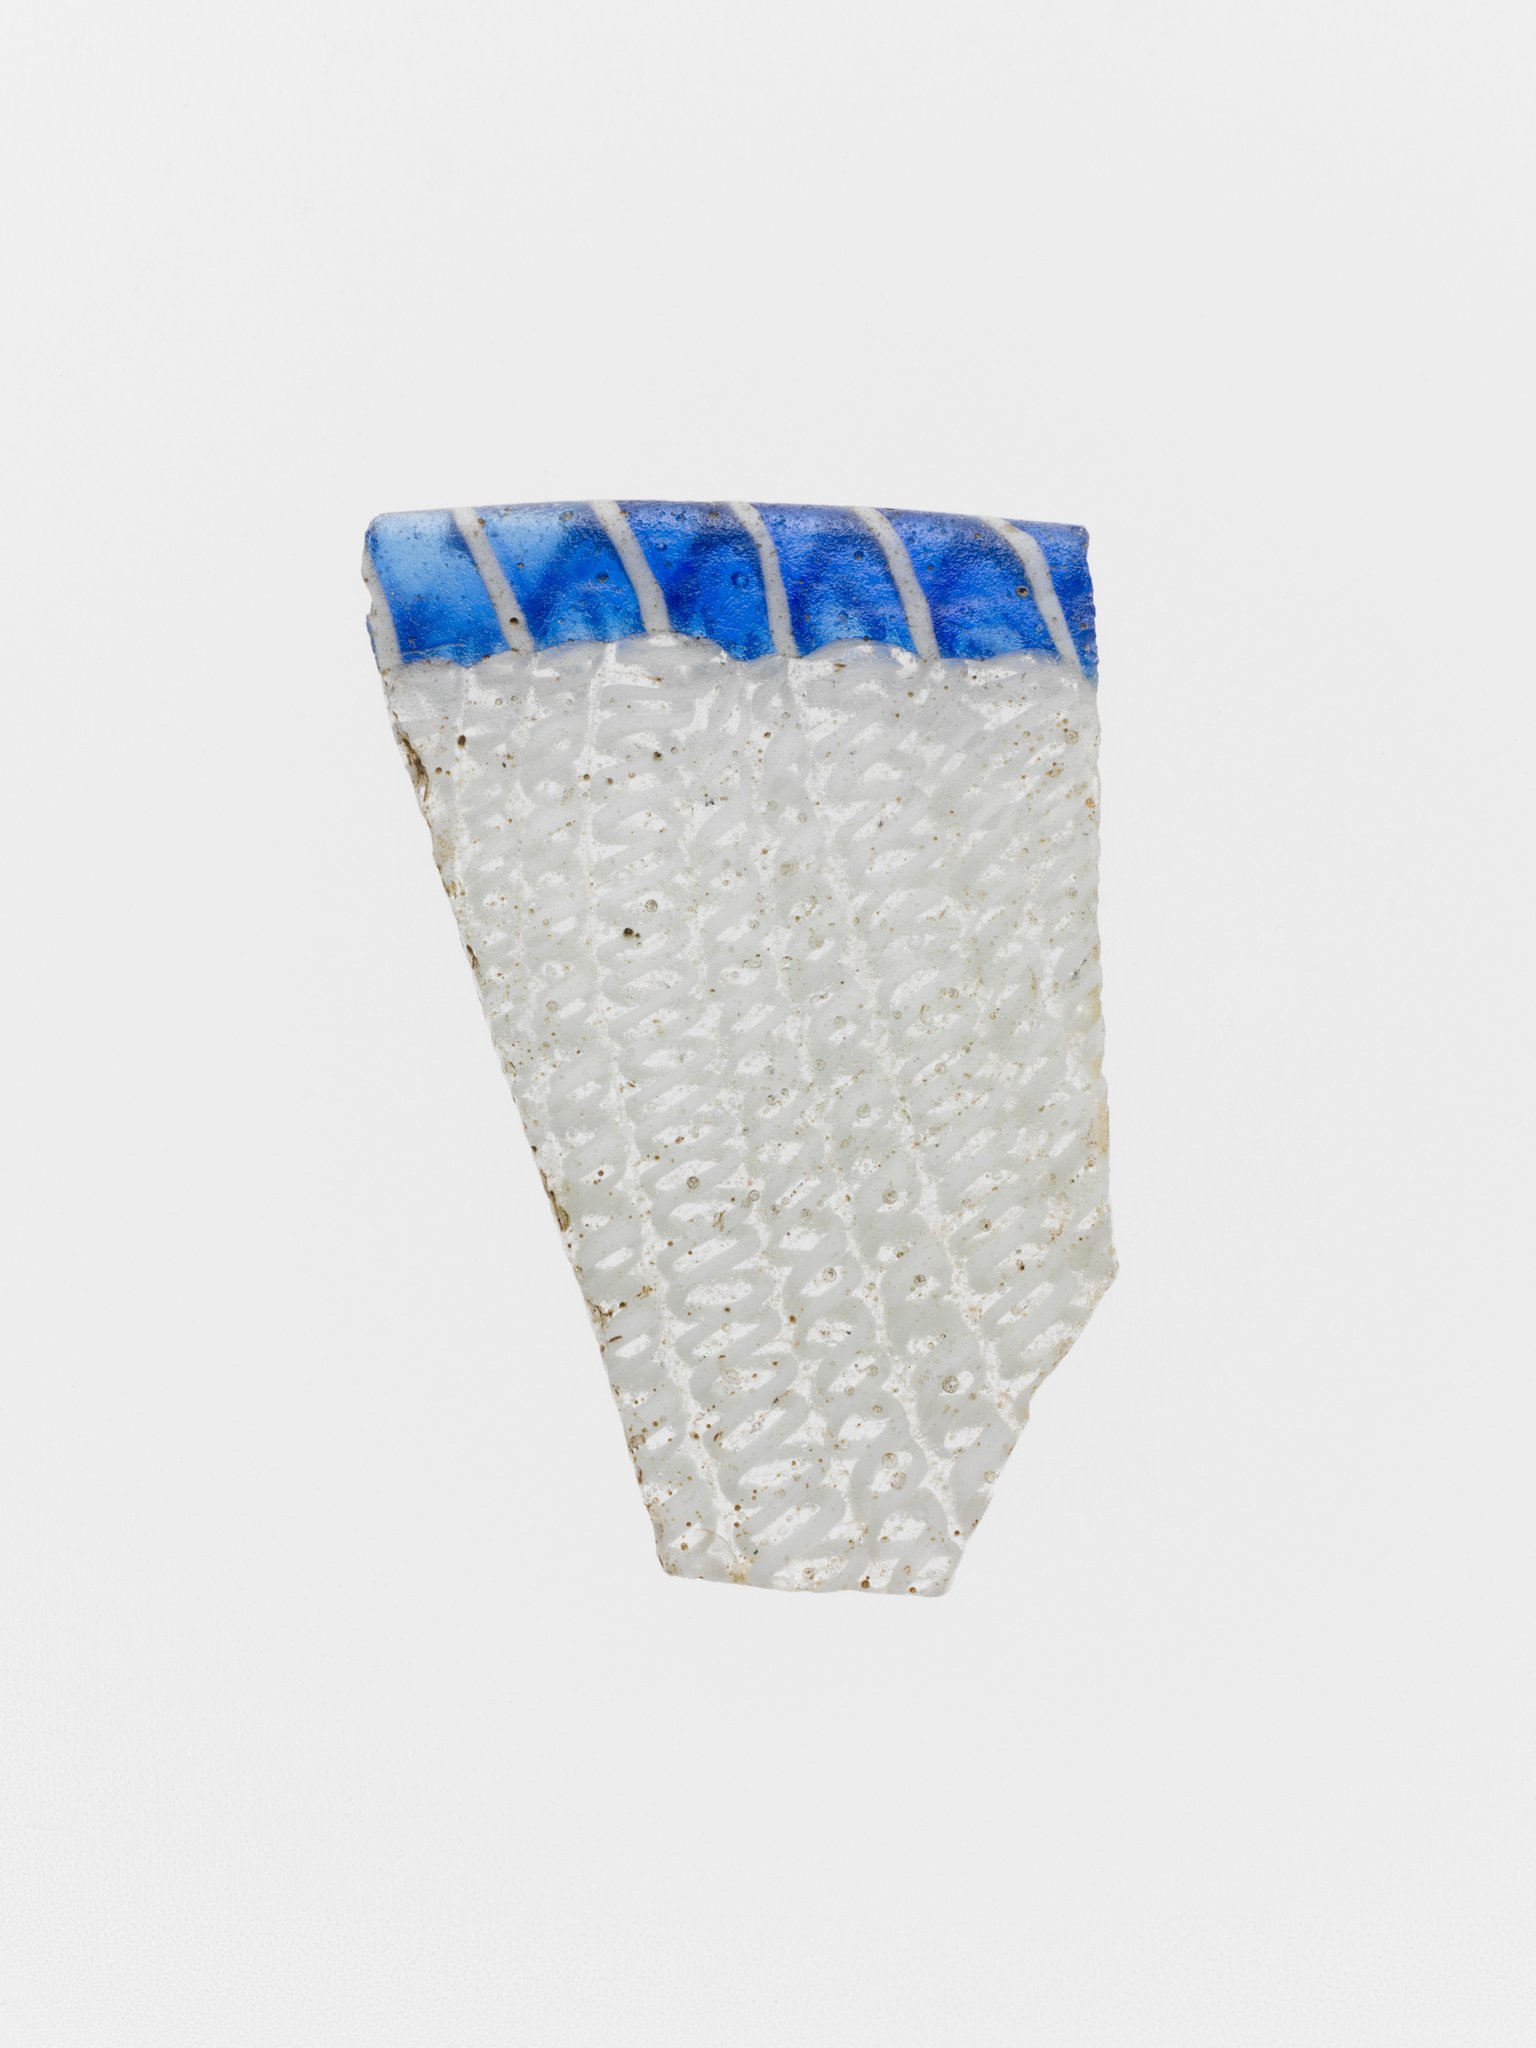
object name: mosaic glass fragment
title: Network mosaic glass fragment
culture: roman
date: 34 BCE-33 CE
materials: glass